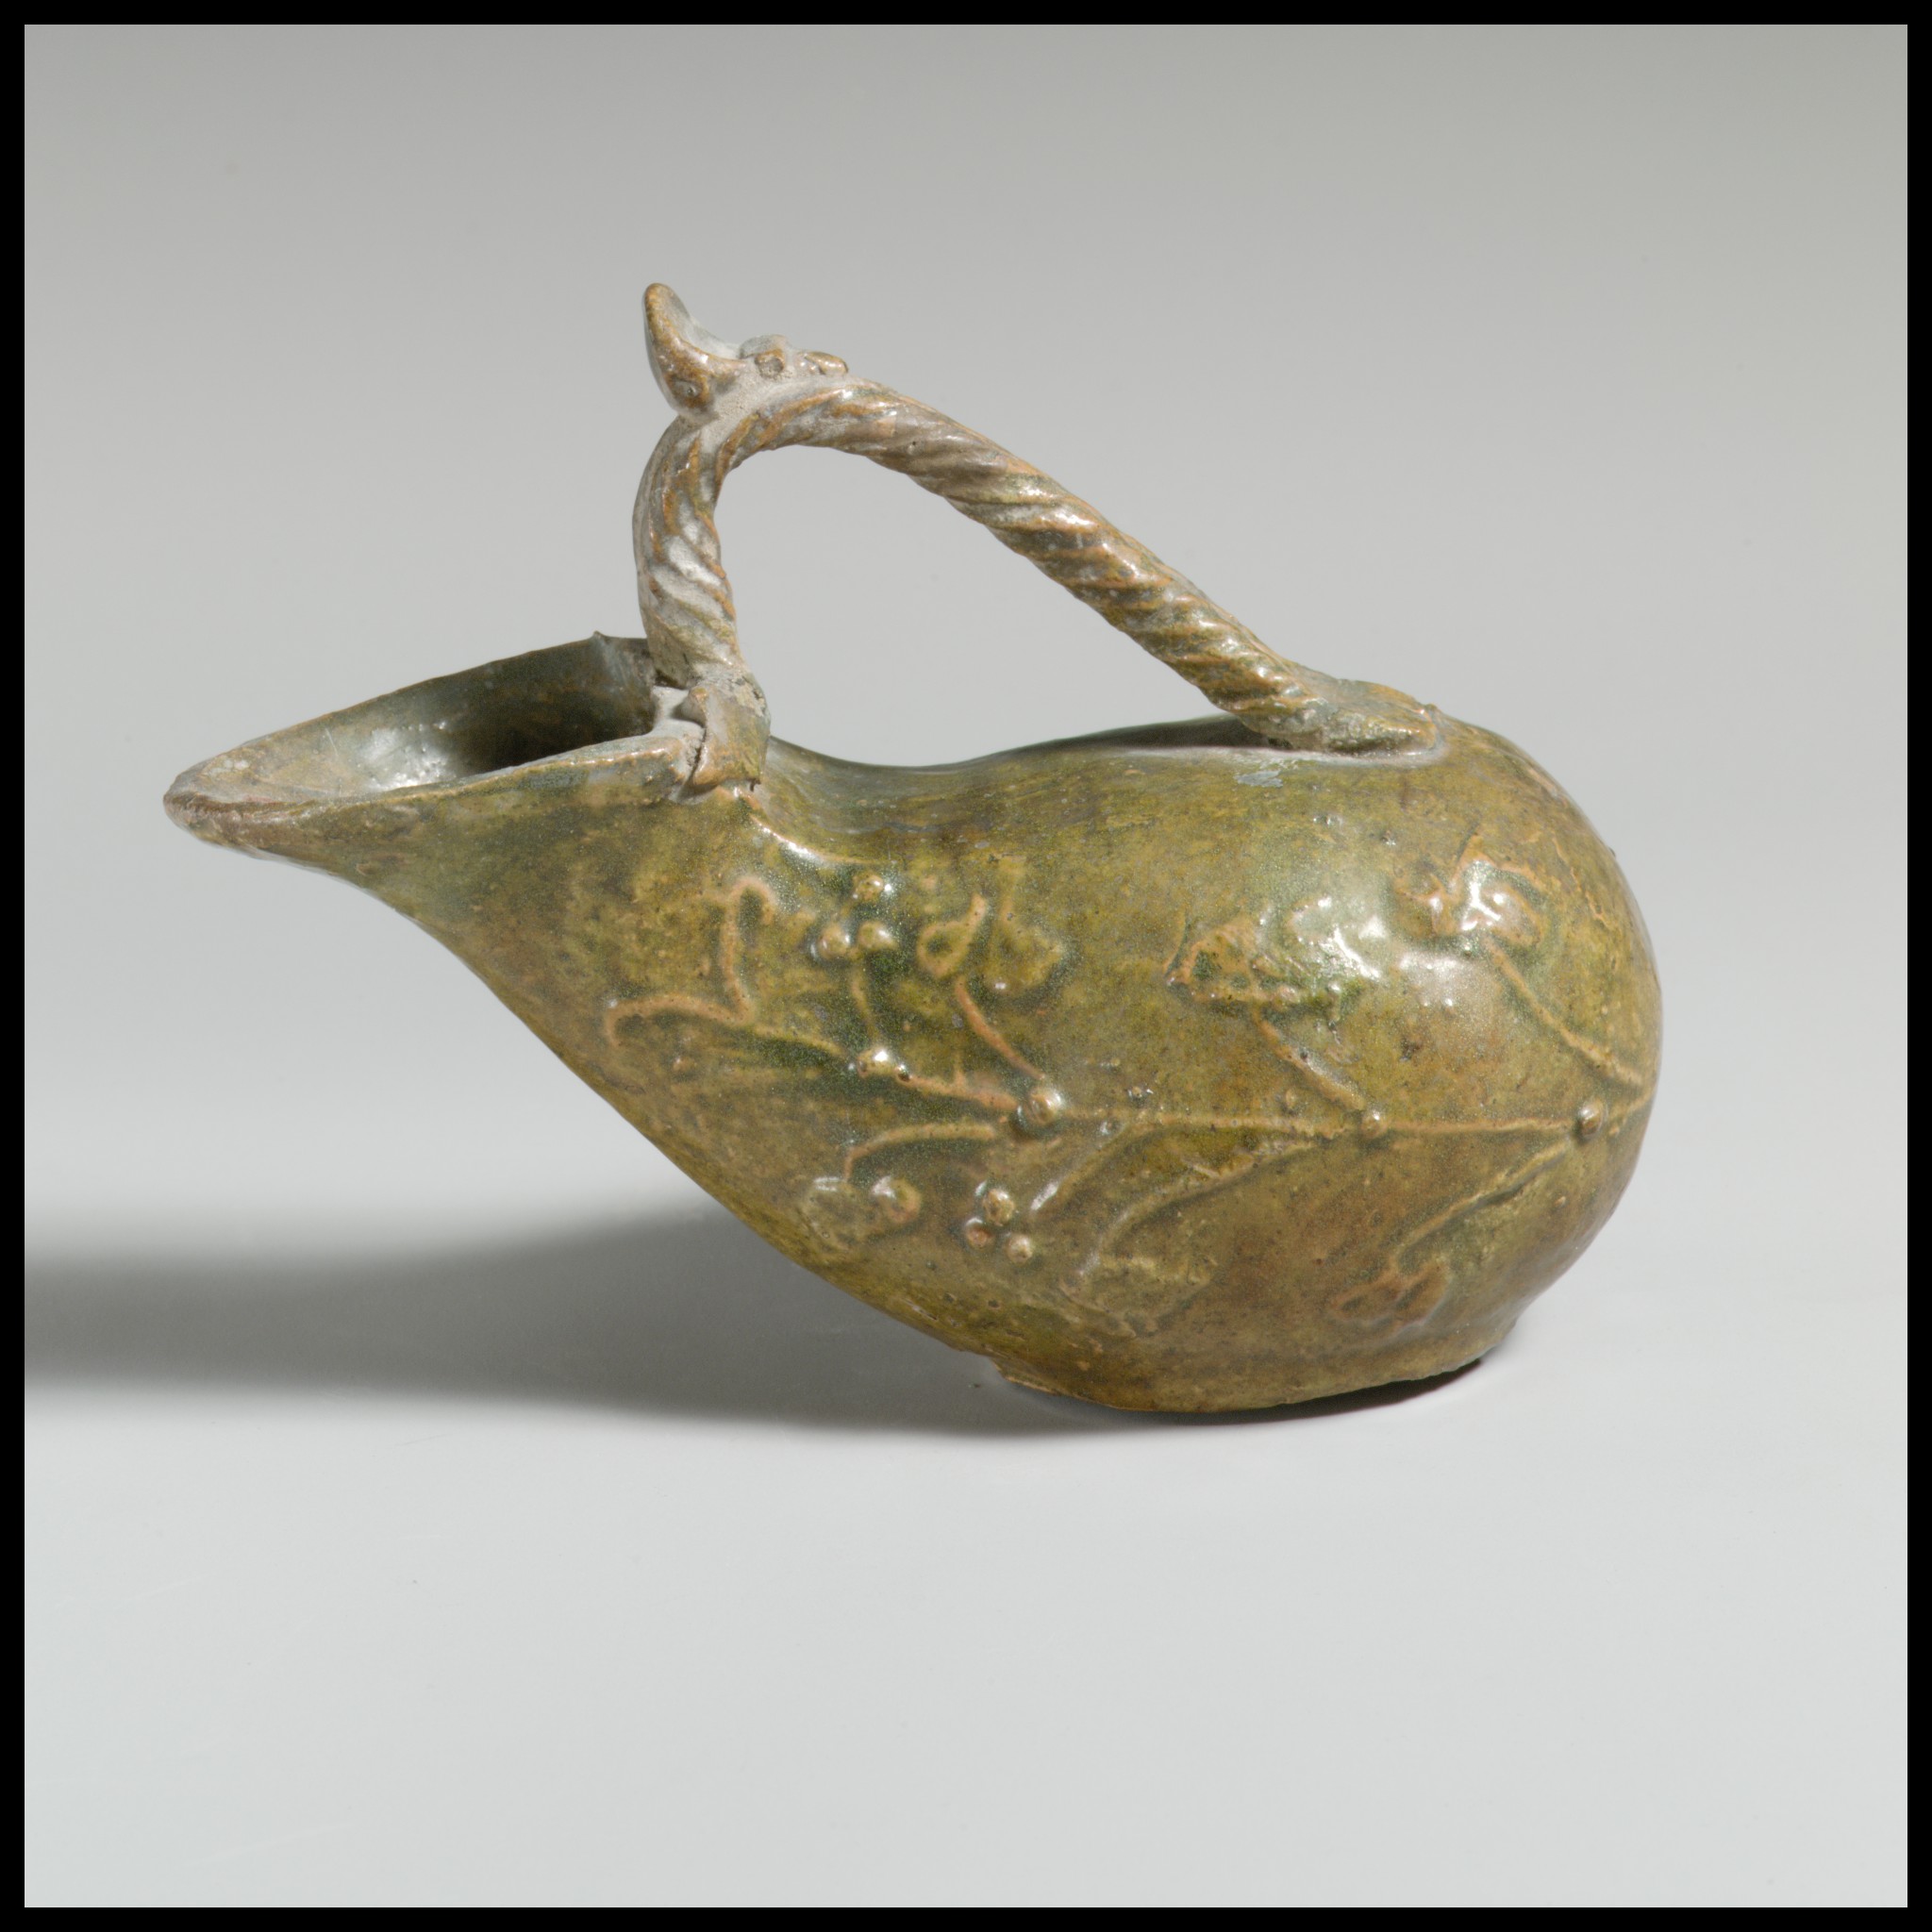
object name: askos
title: Terracotta askos (flask with a spout and handle over the top)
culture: roman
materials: terracotta